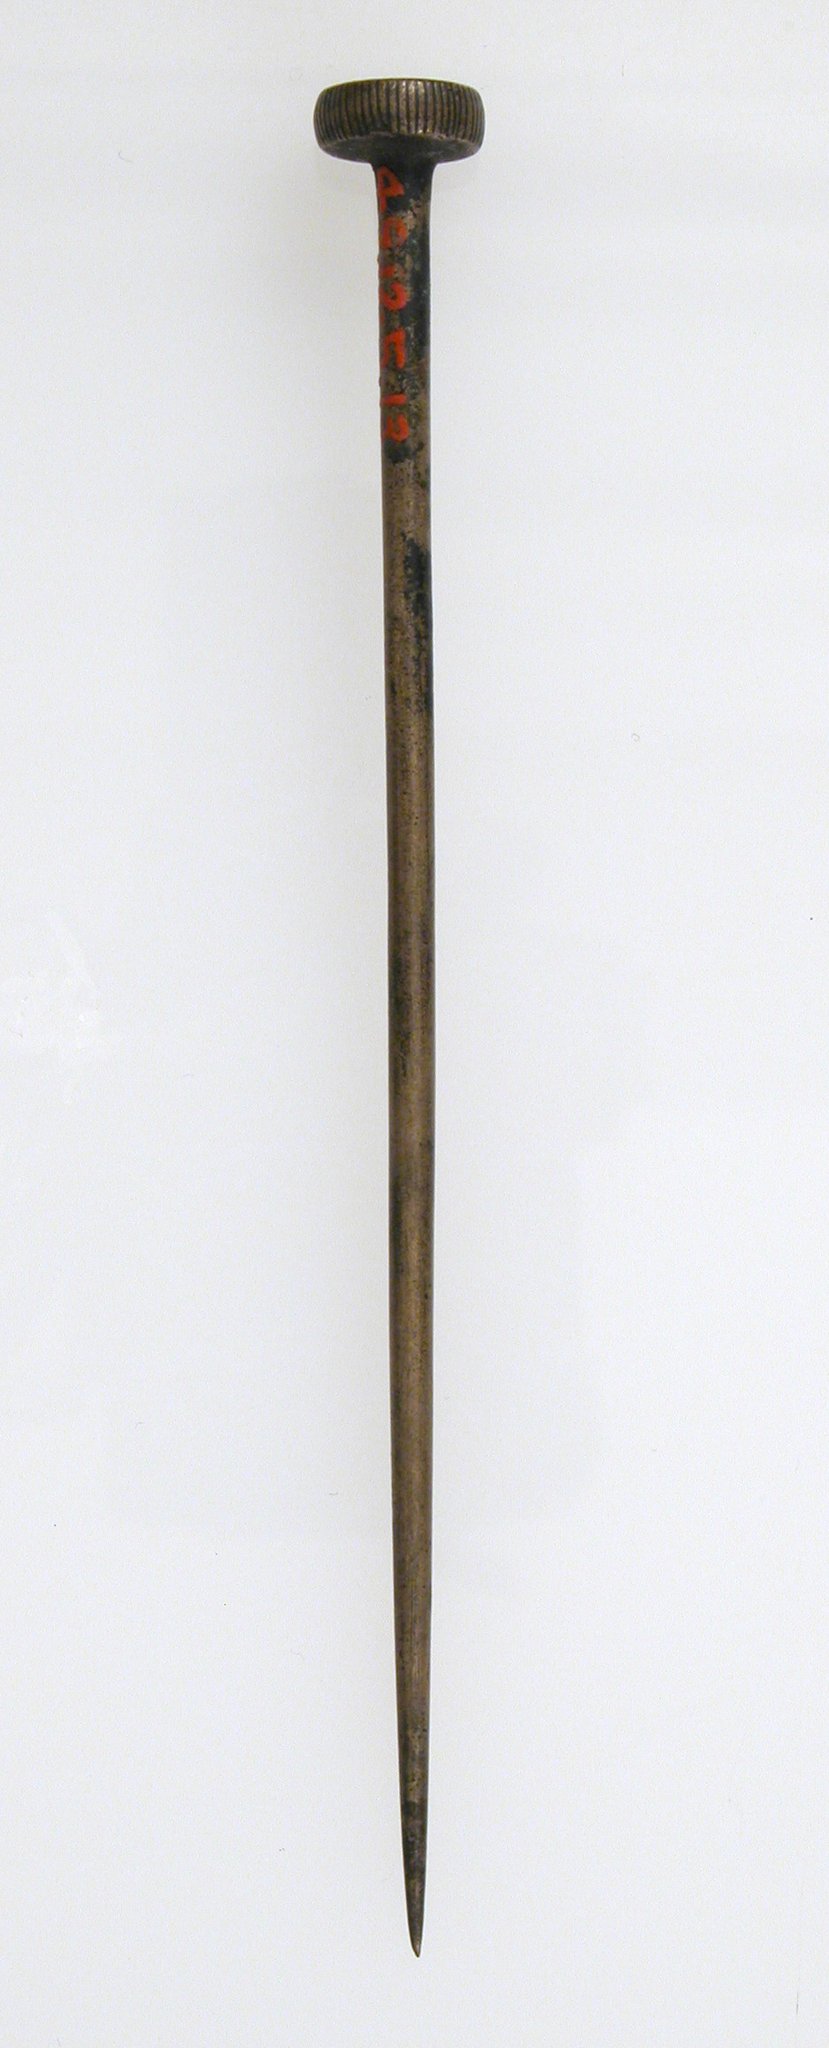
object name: pin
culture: irish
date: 901-1000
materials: copper alloy